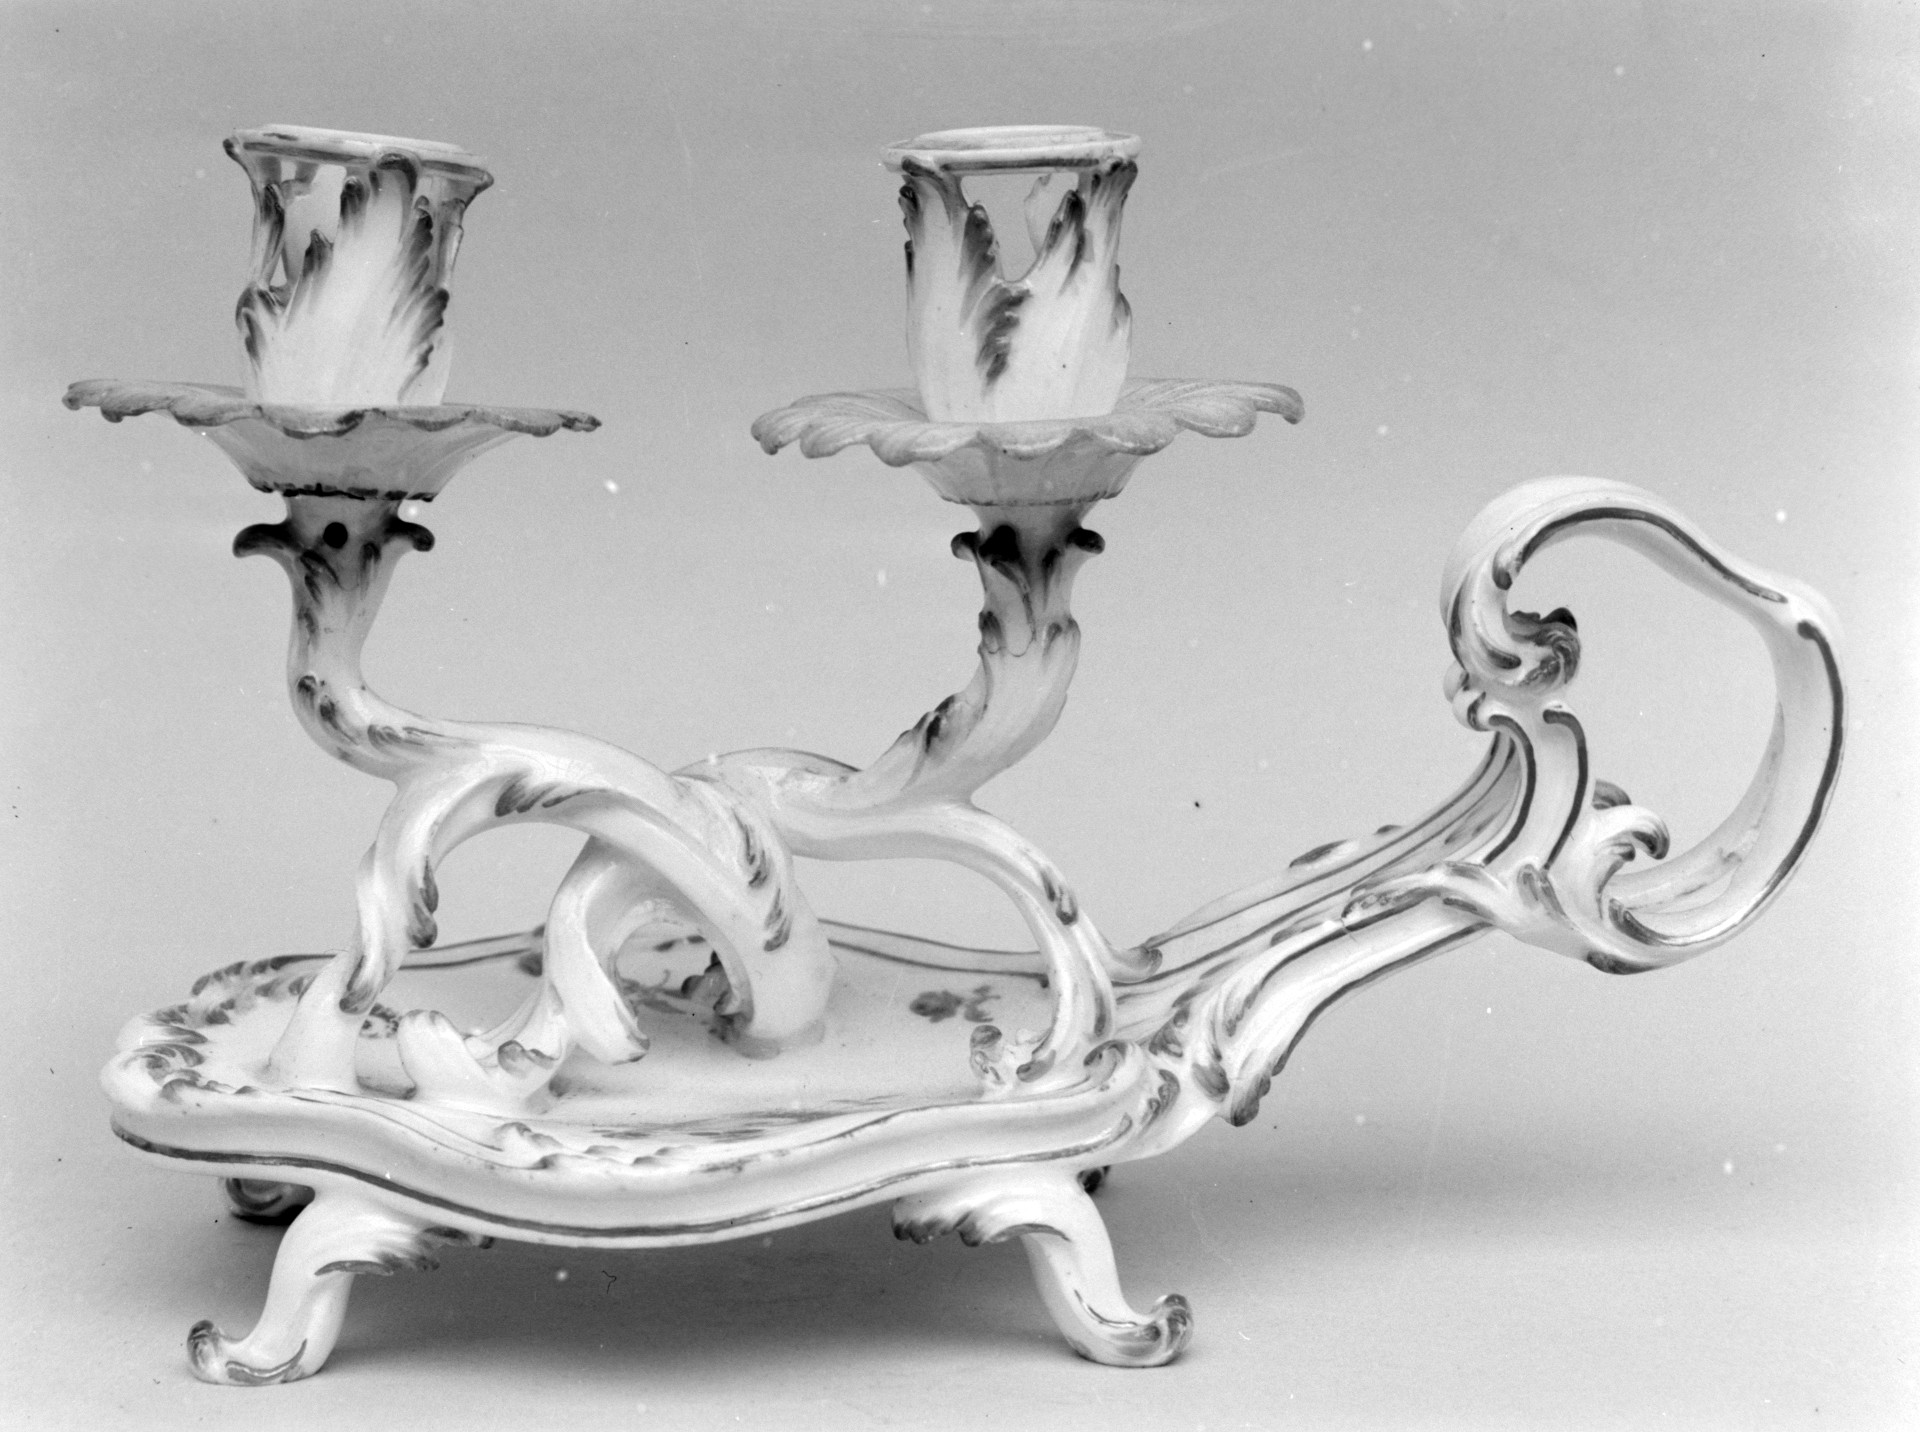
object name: chamber candlestick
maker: meissen manufactory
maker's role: manufactory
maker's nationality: german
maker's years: 1710-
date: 1765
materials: hard paste porcelain